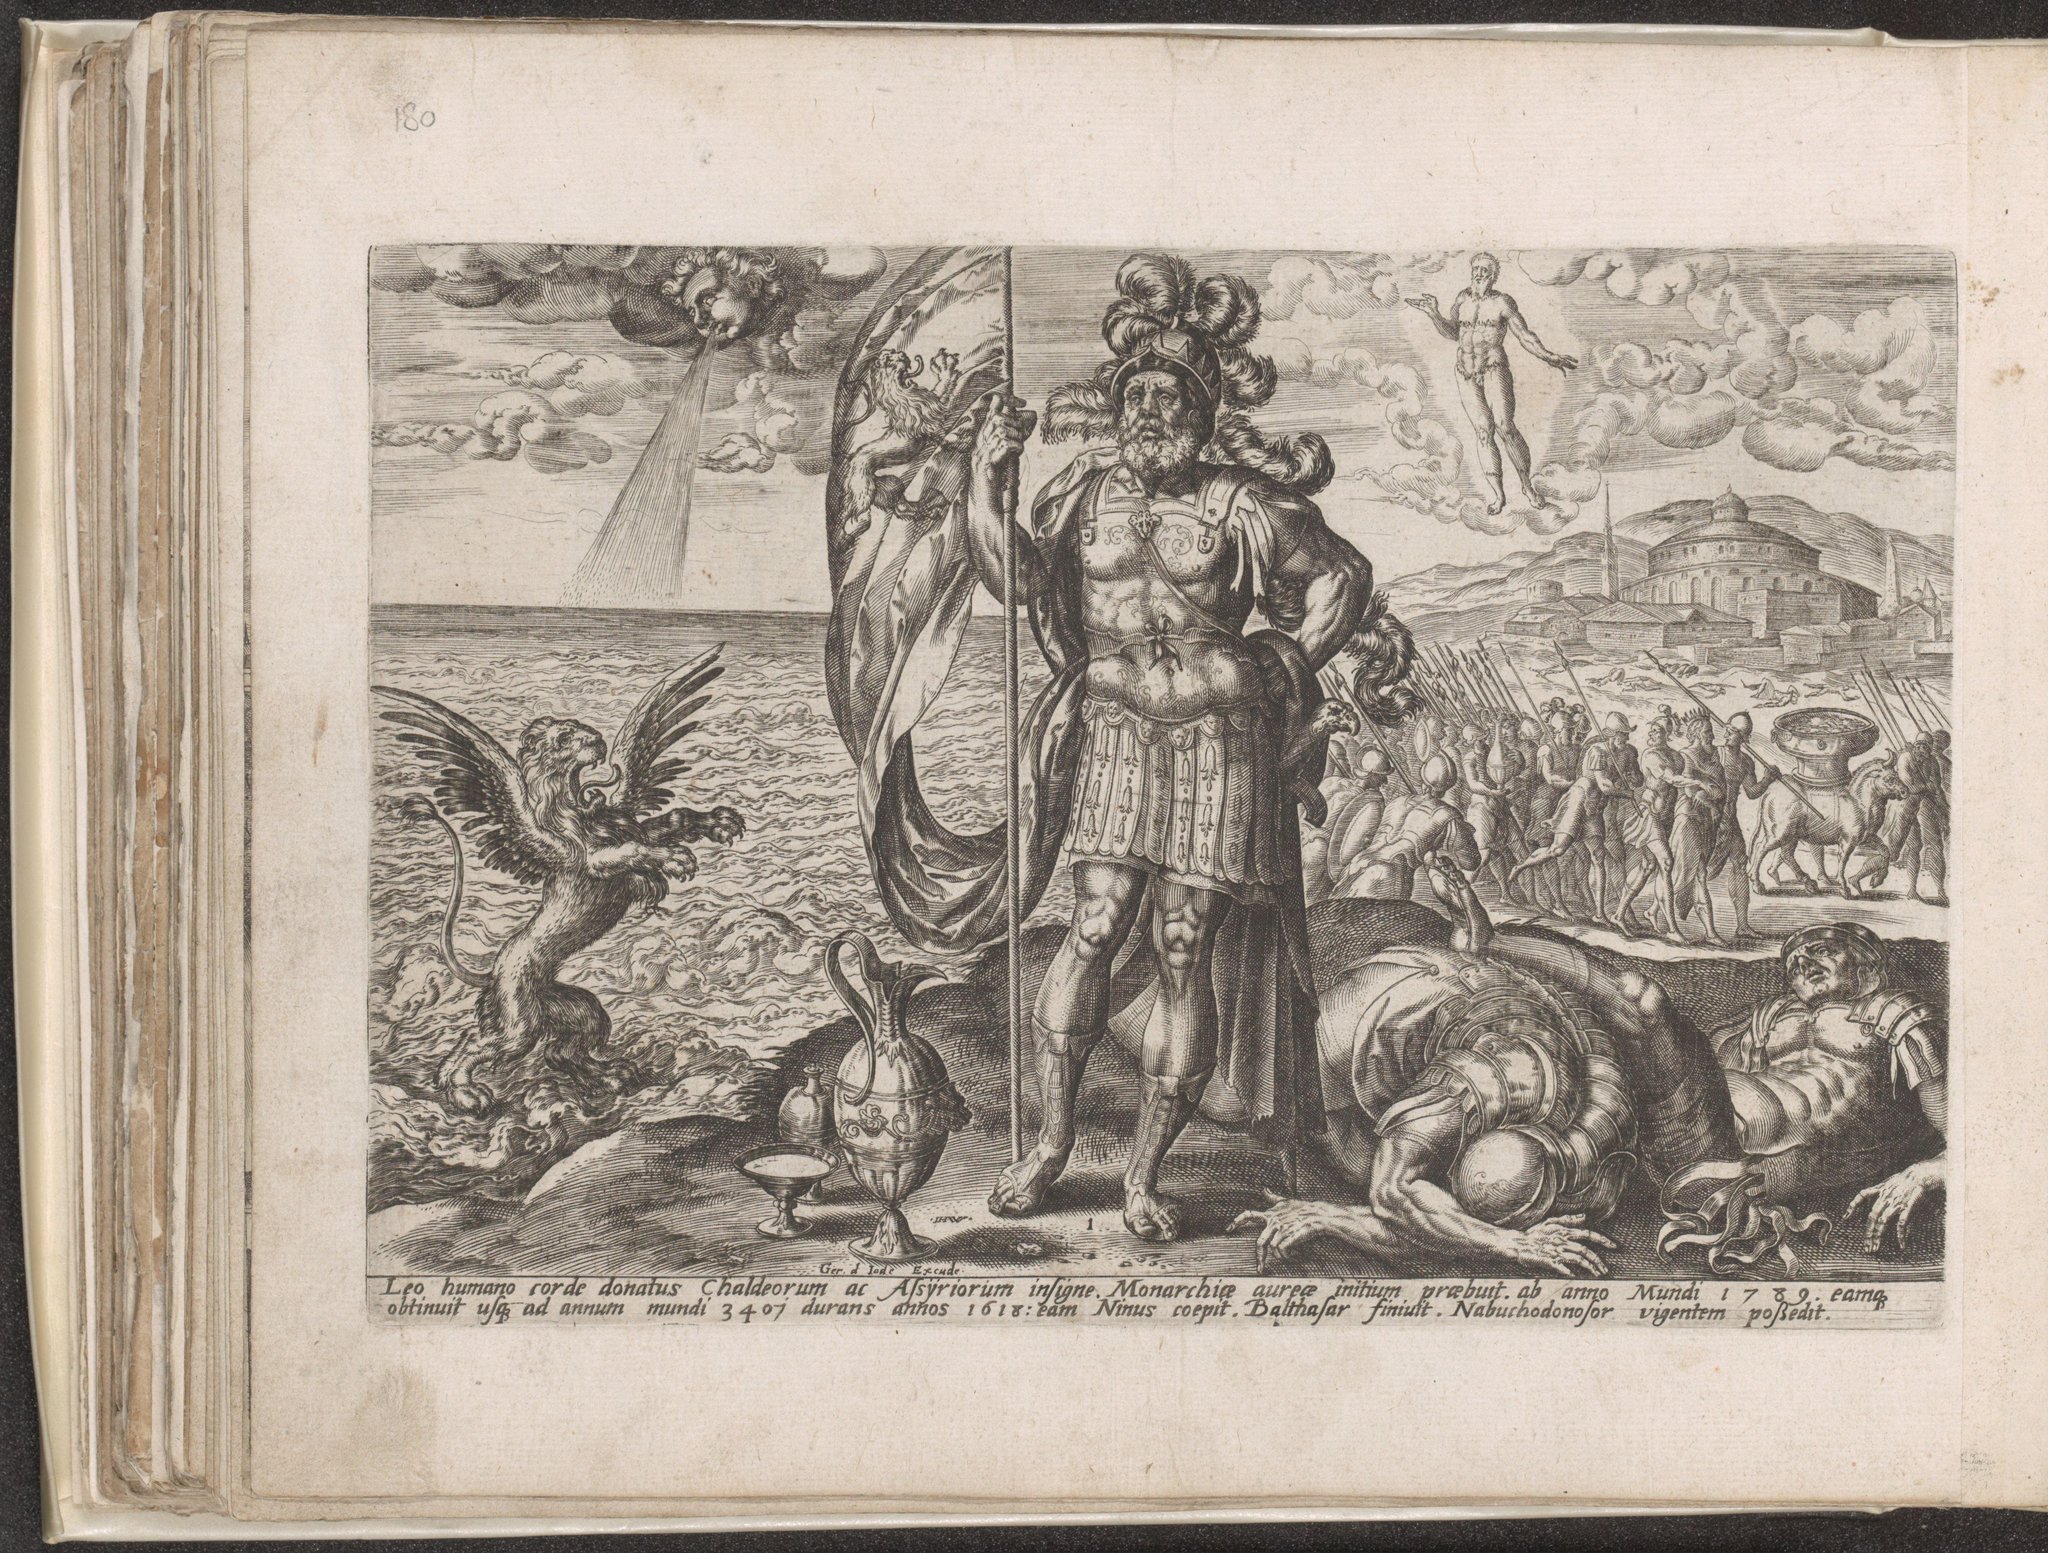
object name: print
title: Vier koninkrijken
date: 1574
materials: paper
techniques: engraving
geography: antwerp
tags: the lion with eagle's wings (griffin), standing on its hind legs ~ daniel's visions, nebuchadnezzar captures the city; jehoiachin, his mother, his wives, and the royal princes are carried away as prisoners (first siege of jerusalem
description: Koning Nebukadnessar staande in strijdtenue triomferend op het slagveld. Aan zijn voeten liggen verslagen mannen. Op de achtergrond een van zijn overwinningen: een overwonnen koning wordt door soldaten weggevoerd. Links rijst een leeuw met adelaarsvleugels op uit de zee. Het is één van de vier dieren uit het visioen van Daniël. Onder de voorstelling een verklarende tekst in het Latijn. Deze prent maakt deel uit van een album.